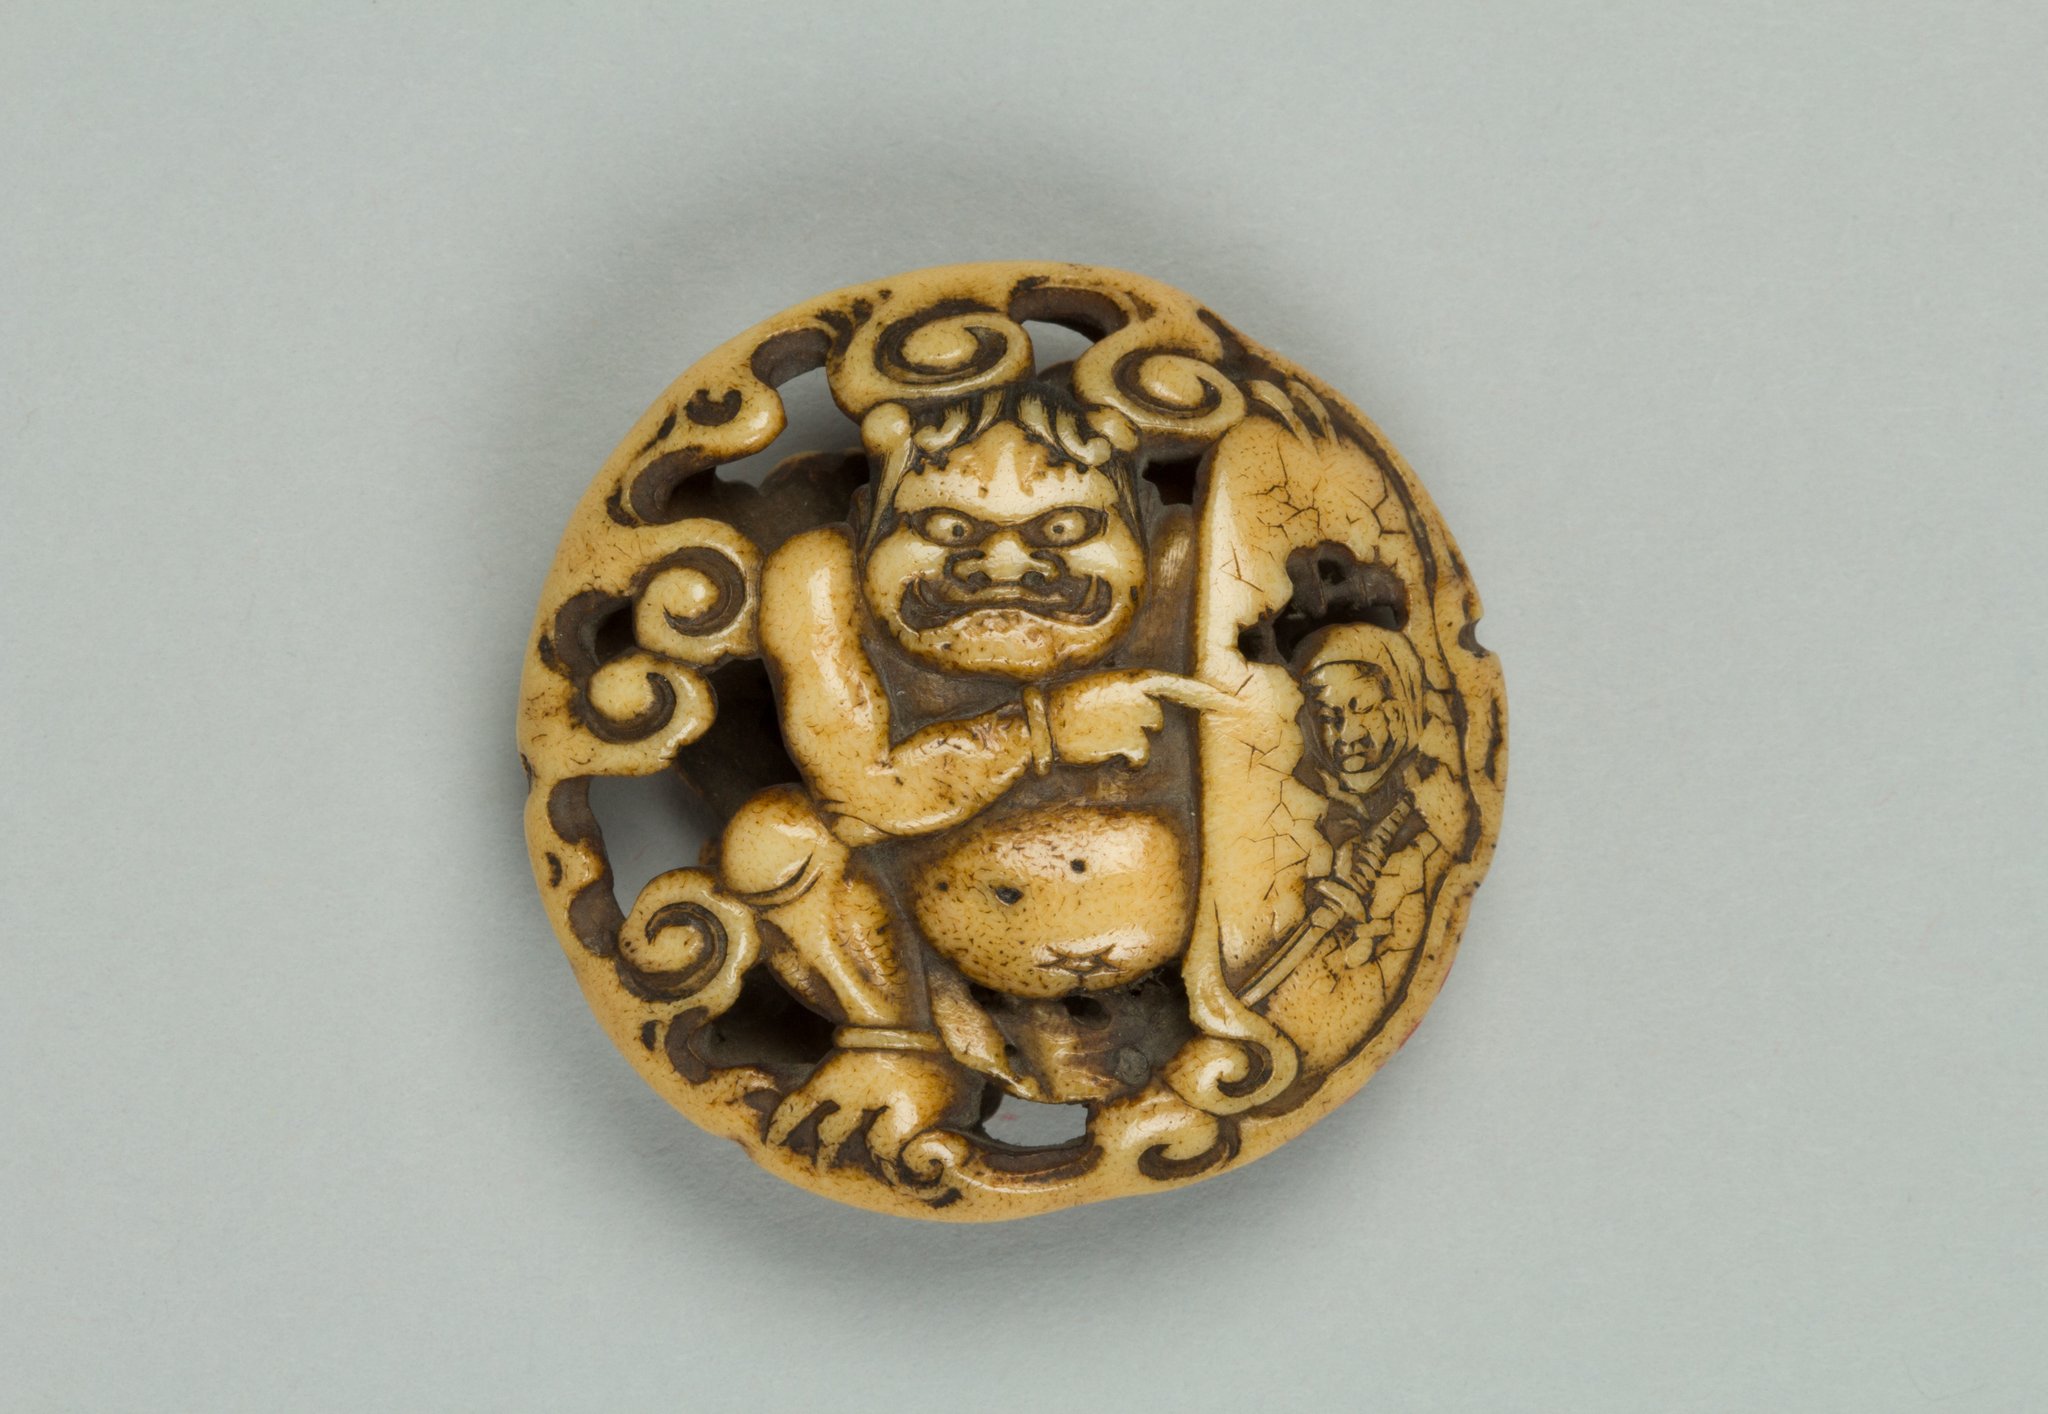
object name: netsuke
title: Netsuke with Carved Demon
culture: japanese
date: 1701-1800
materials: bone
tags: demons